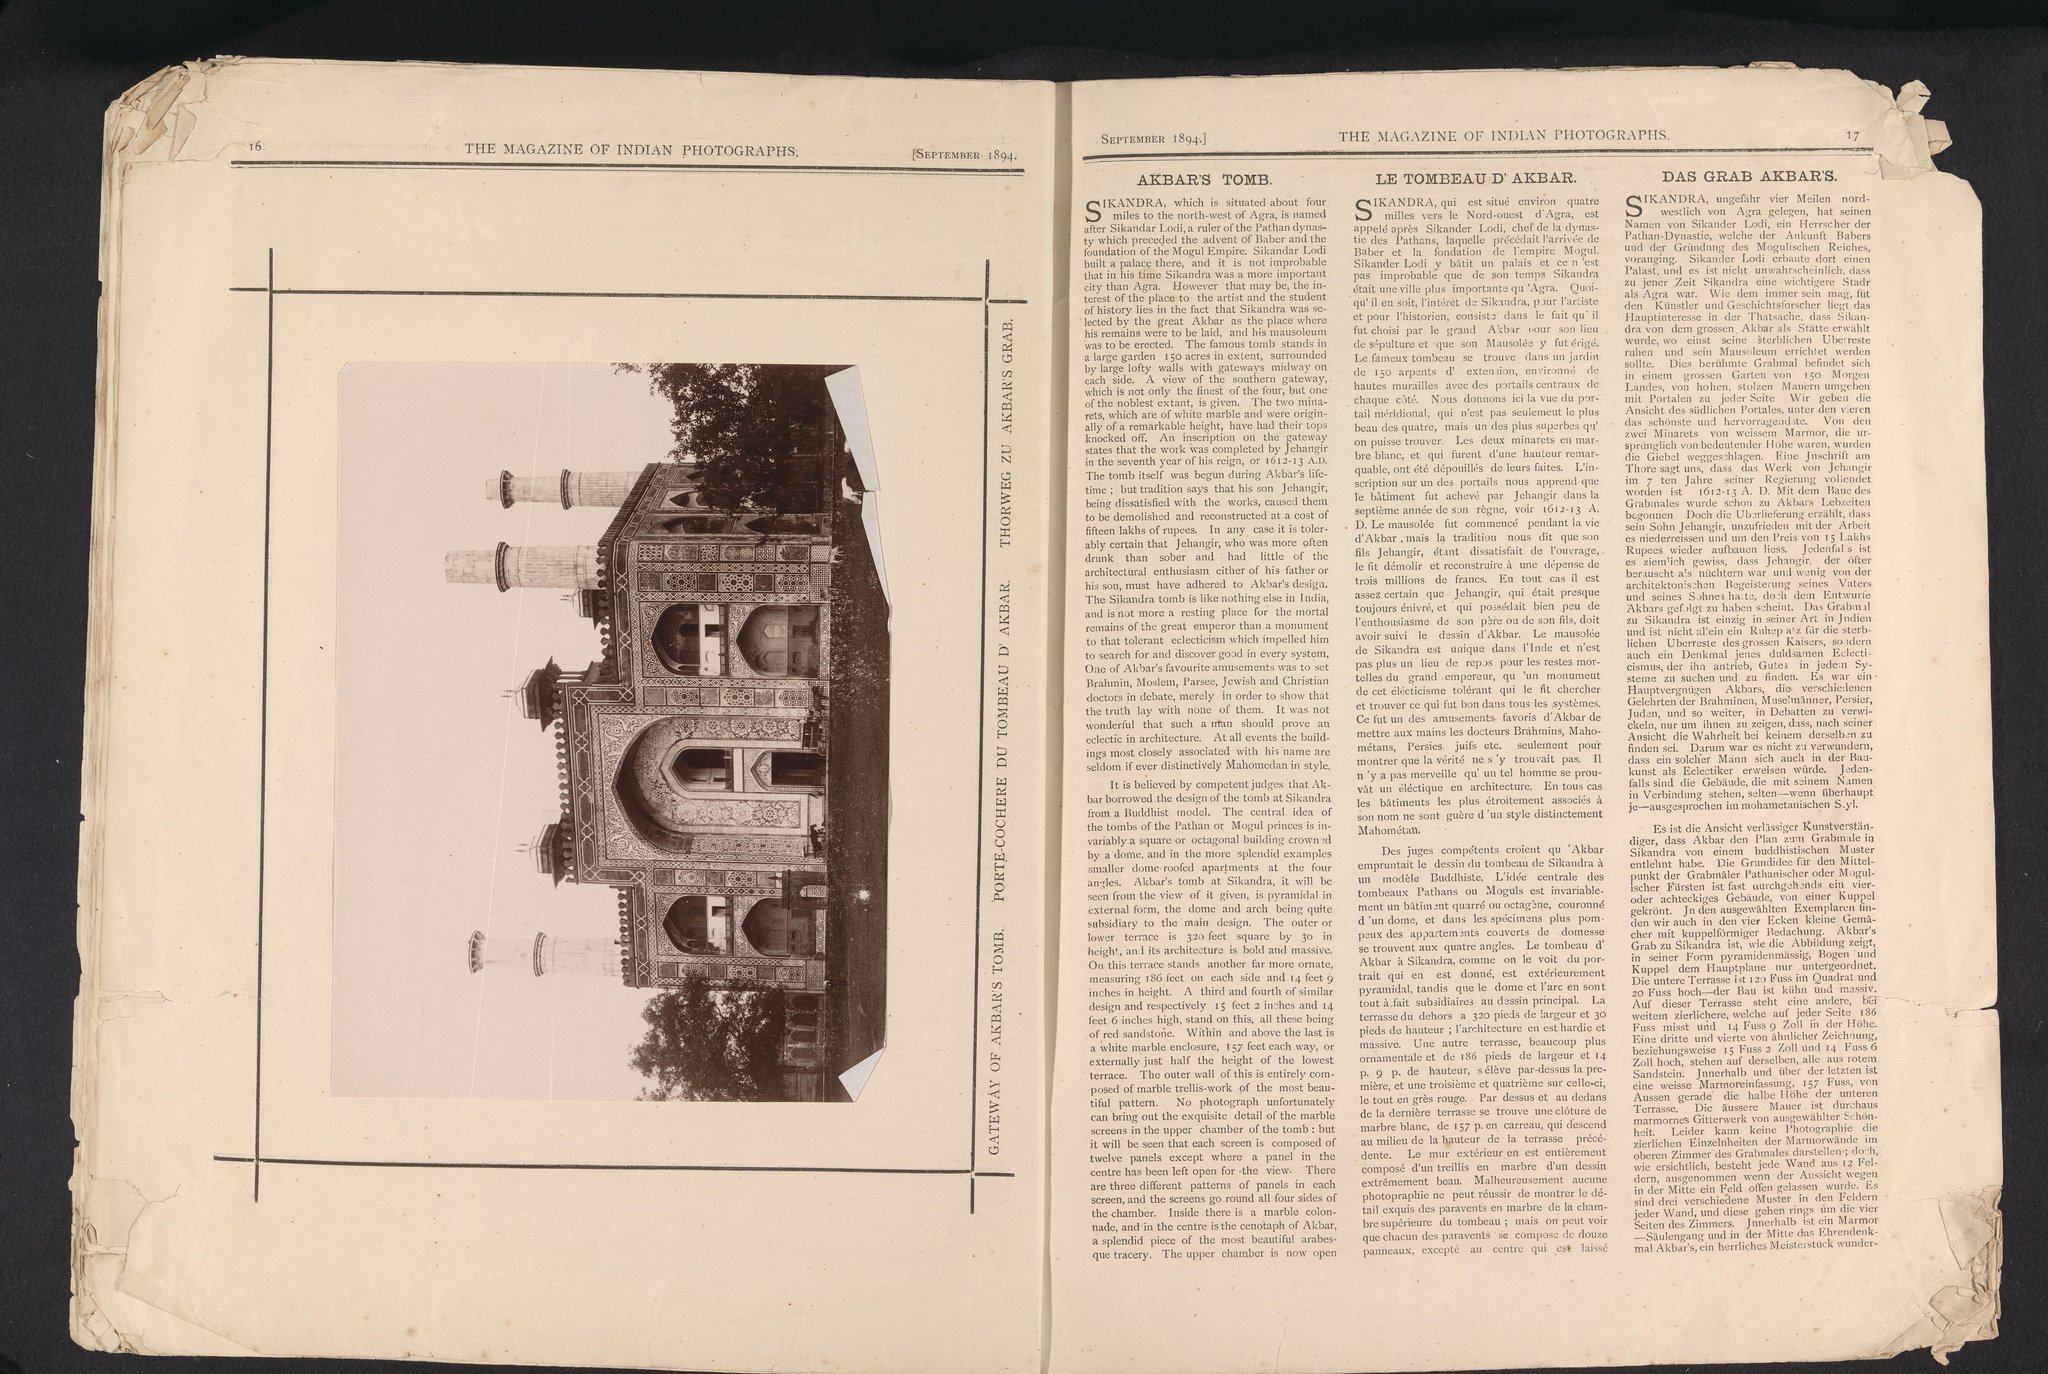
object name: photograph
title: View of the entrance gate of Akbar's Mausoleum at Sikandra, Uttar Pradesh, India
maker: Anonymous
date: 1889-1894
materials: photographic support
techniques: albumen print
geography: sikandra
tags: gate, entrance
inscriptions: title: ‘GATEWAY OF AKBAR'S TOMB. PORTE-COCHERE DU TOMBEAU D'AKBAR. THORWEG ZU AKBAR'S GRAB.’